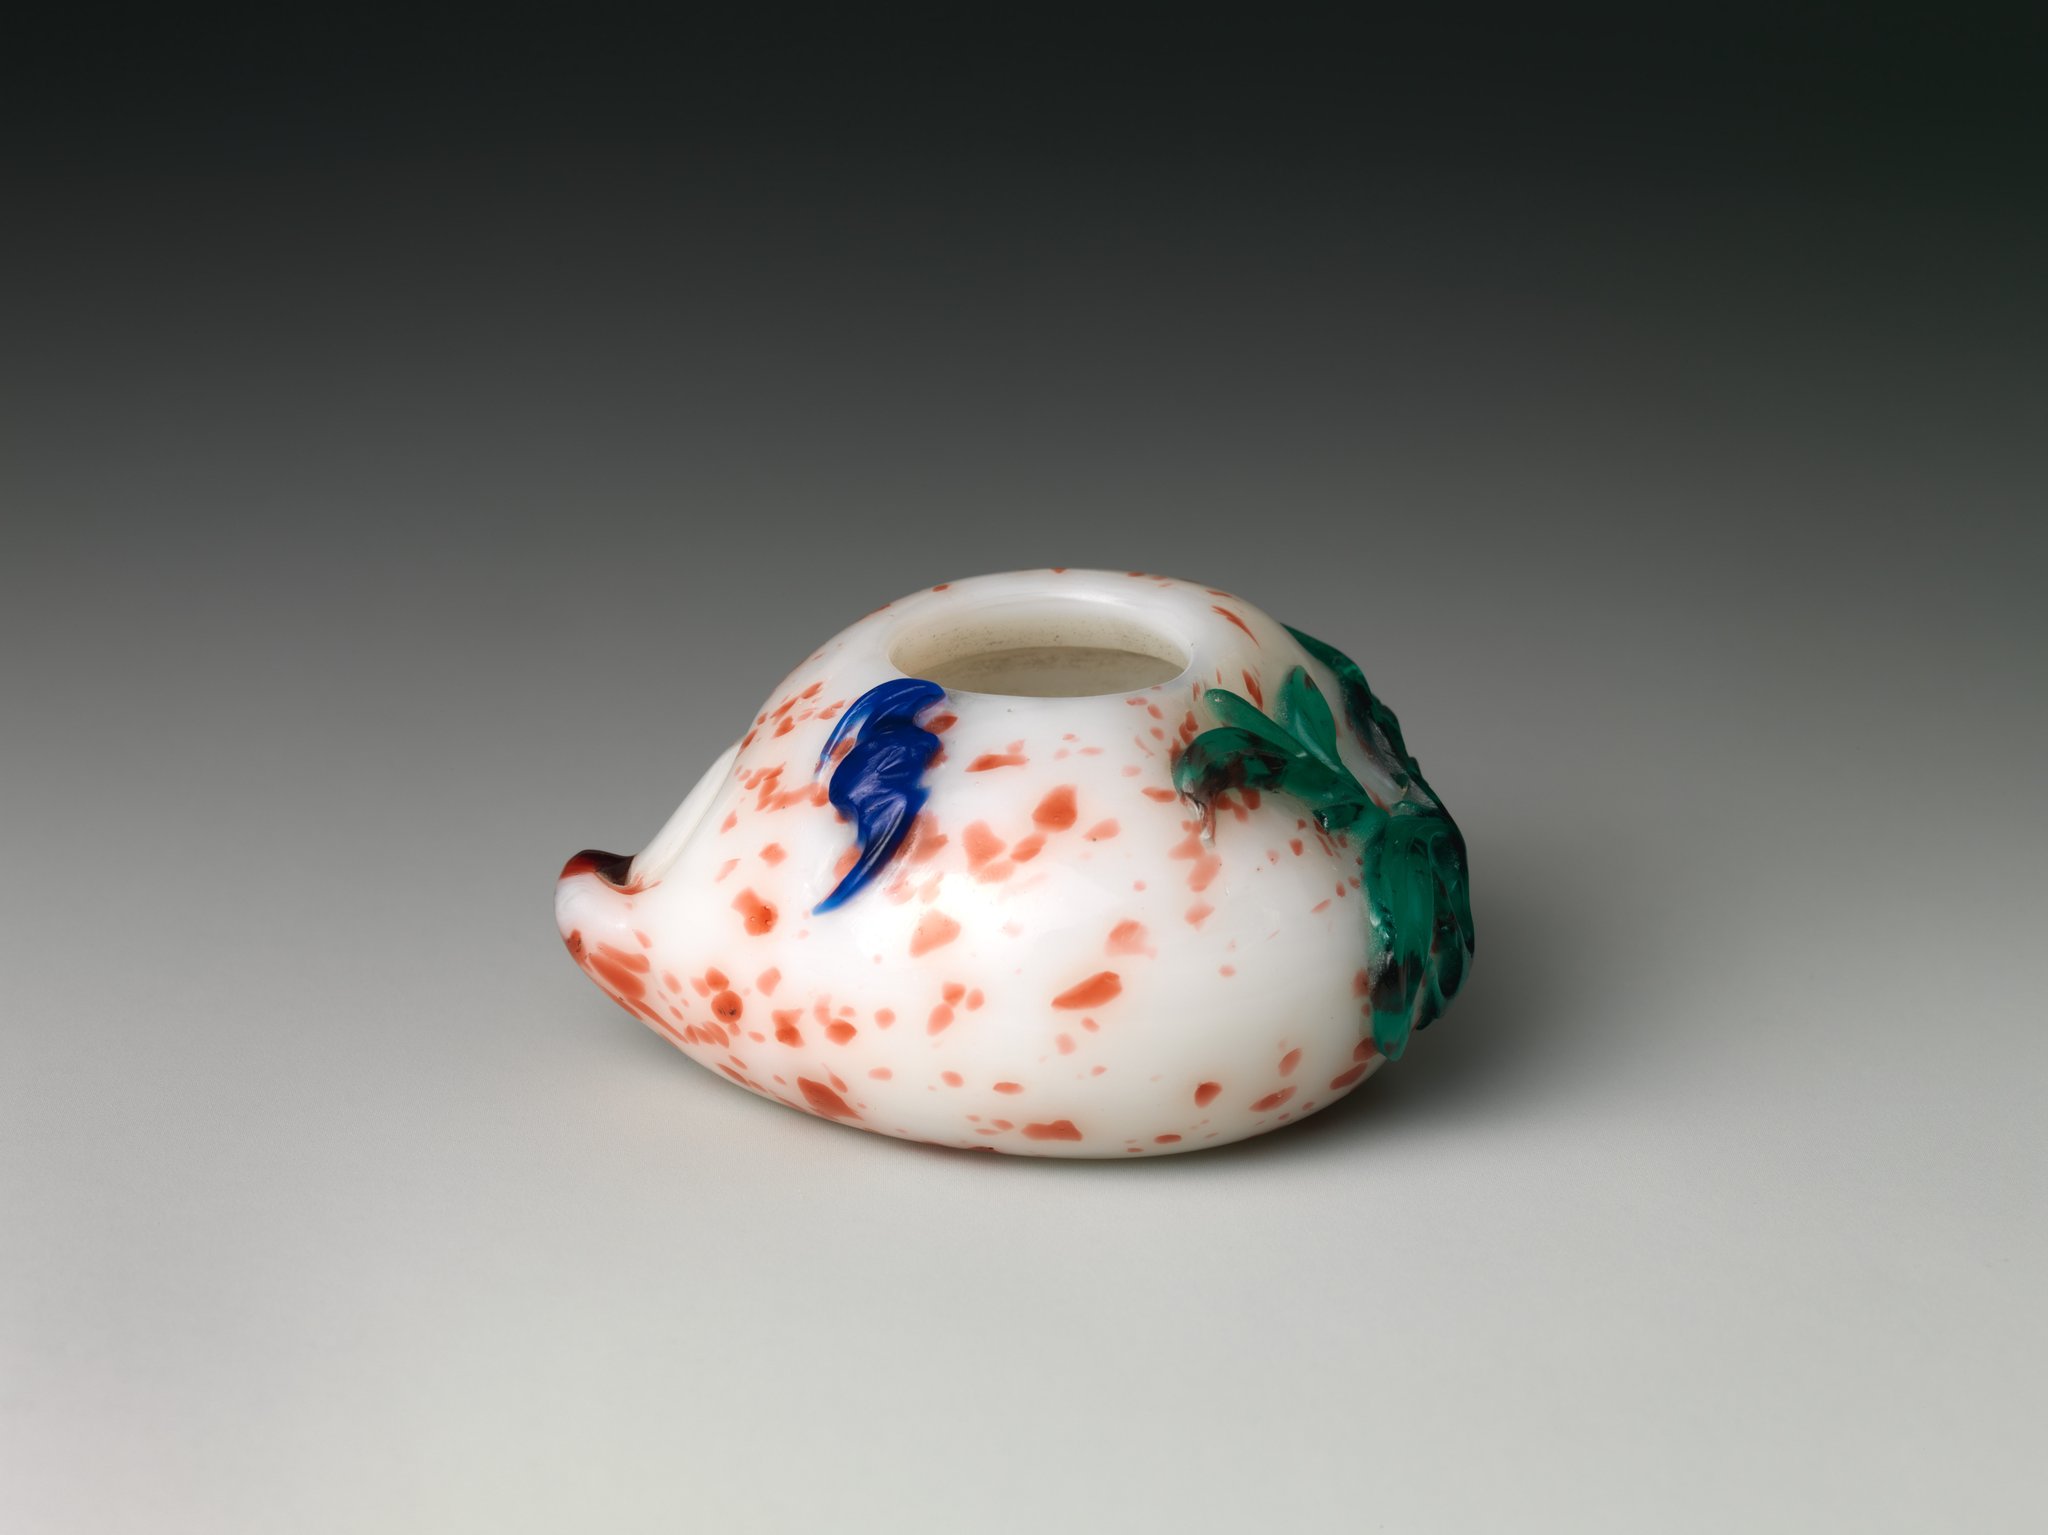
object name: brush washer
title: Brush washer in the shape of a peach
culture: chinese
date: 1701-1800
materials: glass